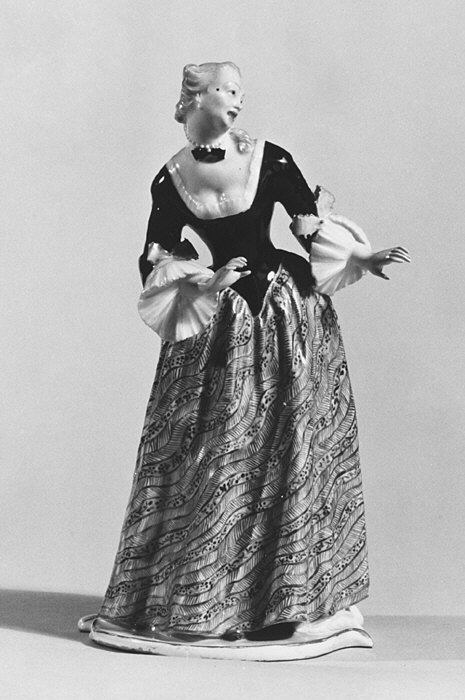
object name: figure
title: Isabella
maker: nymphenburg porcelain manufactory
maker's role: manufactory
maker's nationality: german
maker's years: 1747-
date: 1758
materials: hard paste porcelain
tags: queens